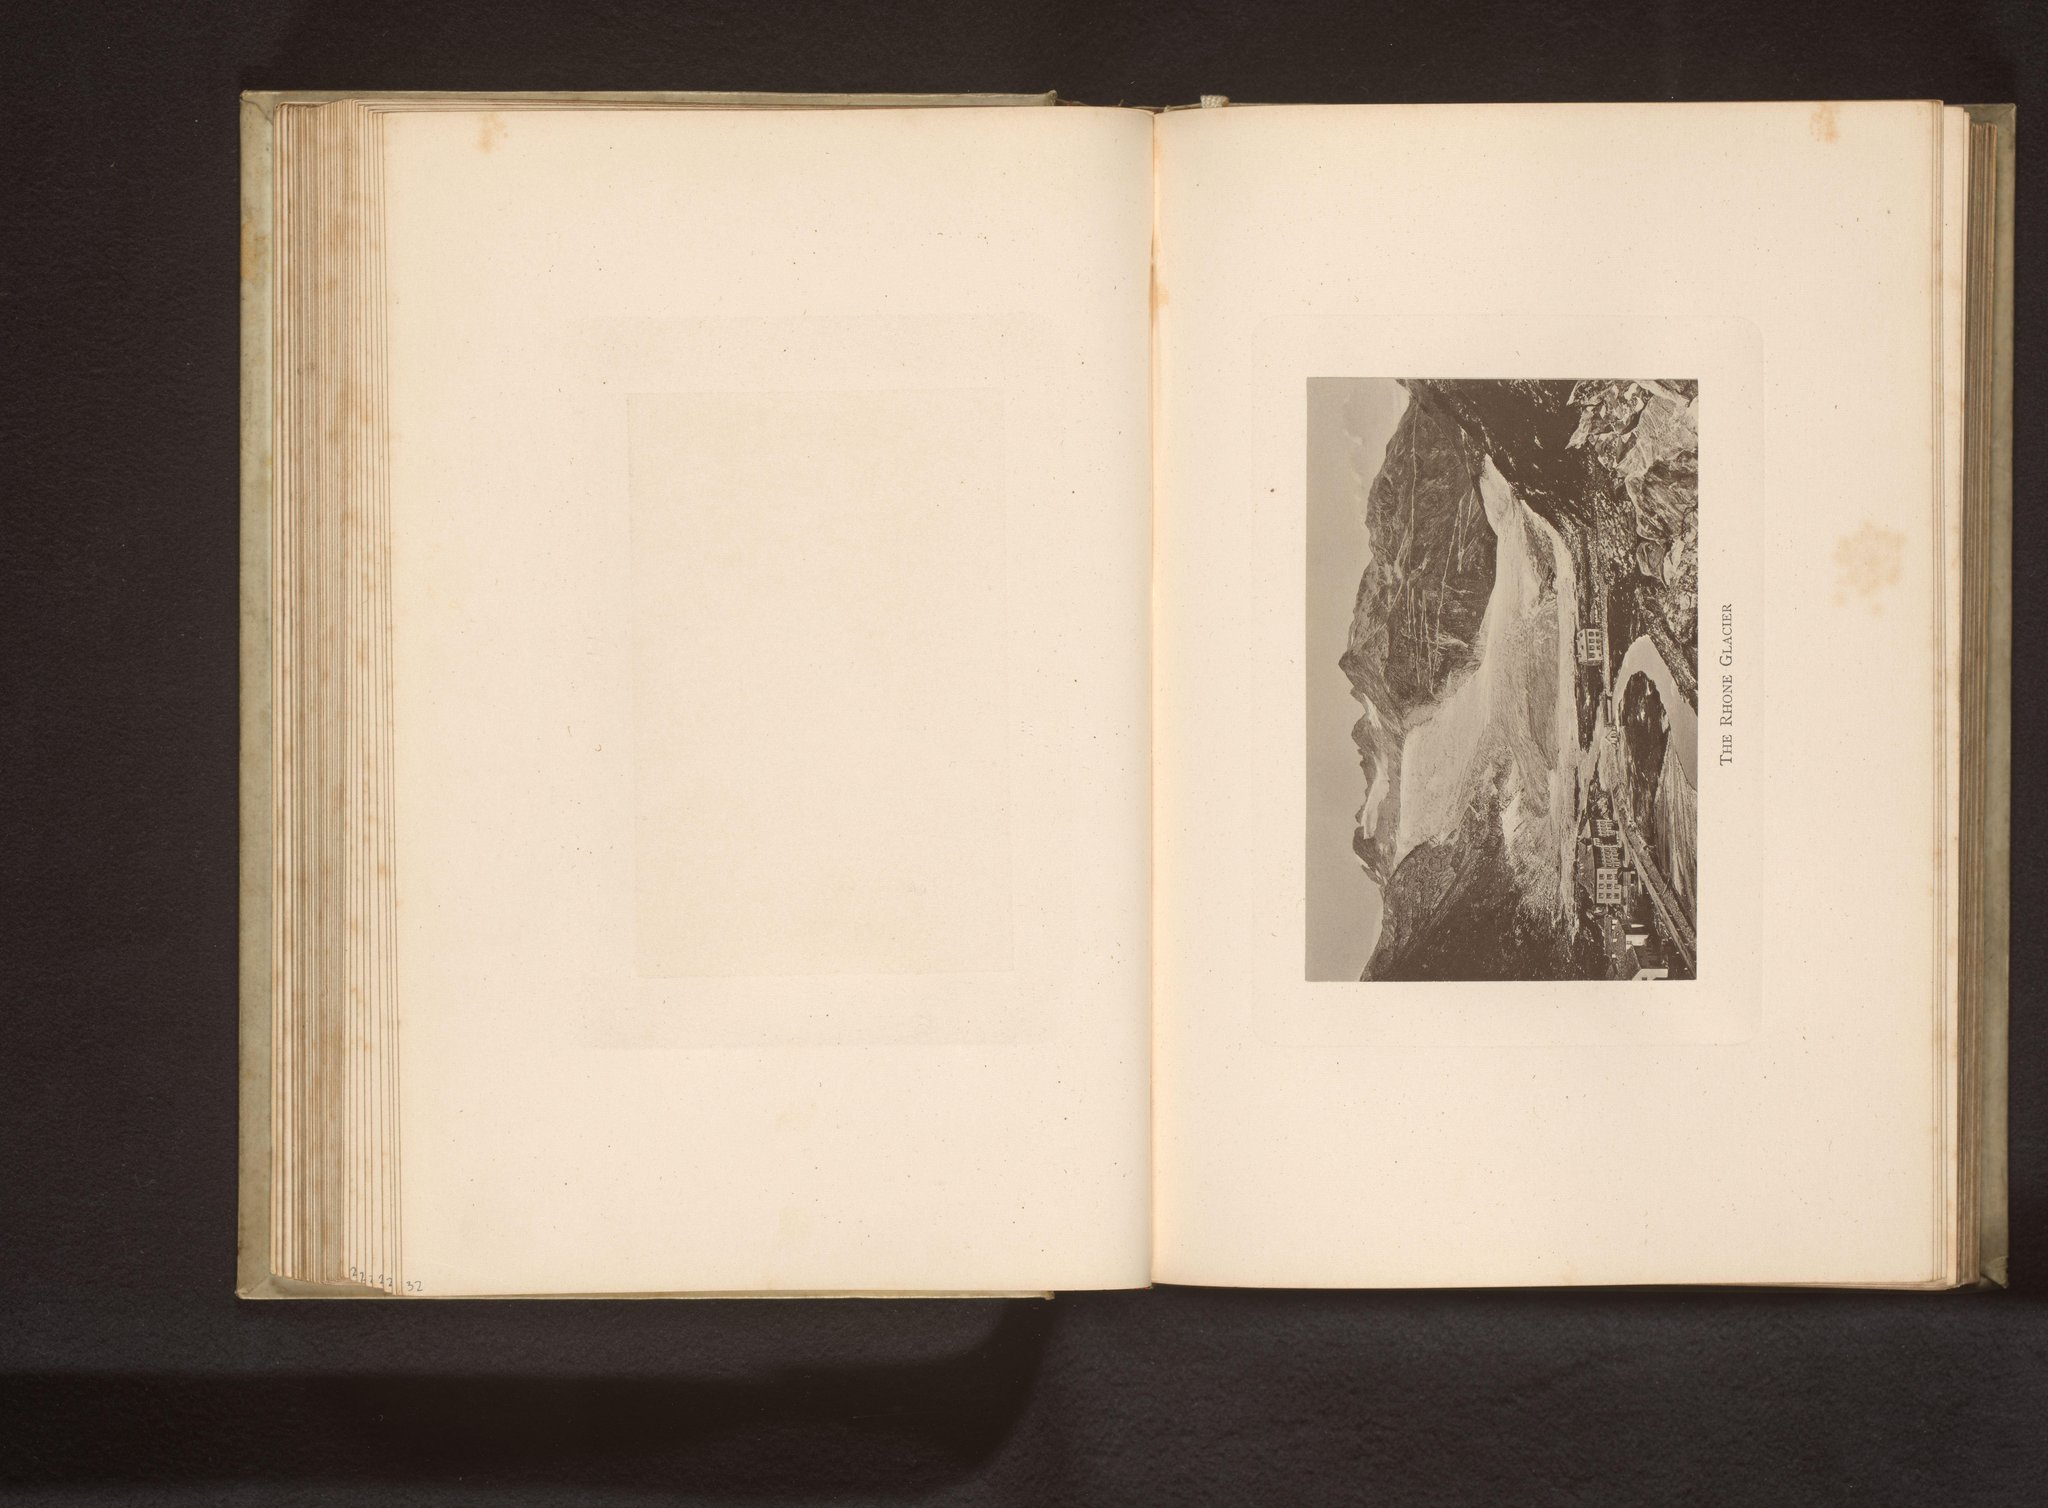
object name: page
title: Gezicht op de Rhônegletsjer in Zwitserland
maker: Anonymous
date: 1874-1884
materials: paper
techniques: photograph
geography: switzerland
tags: glacier